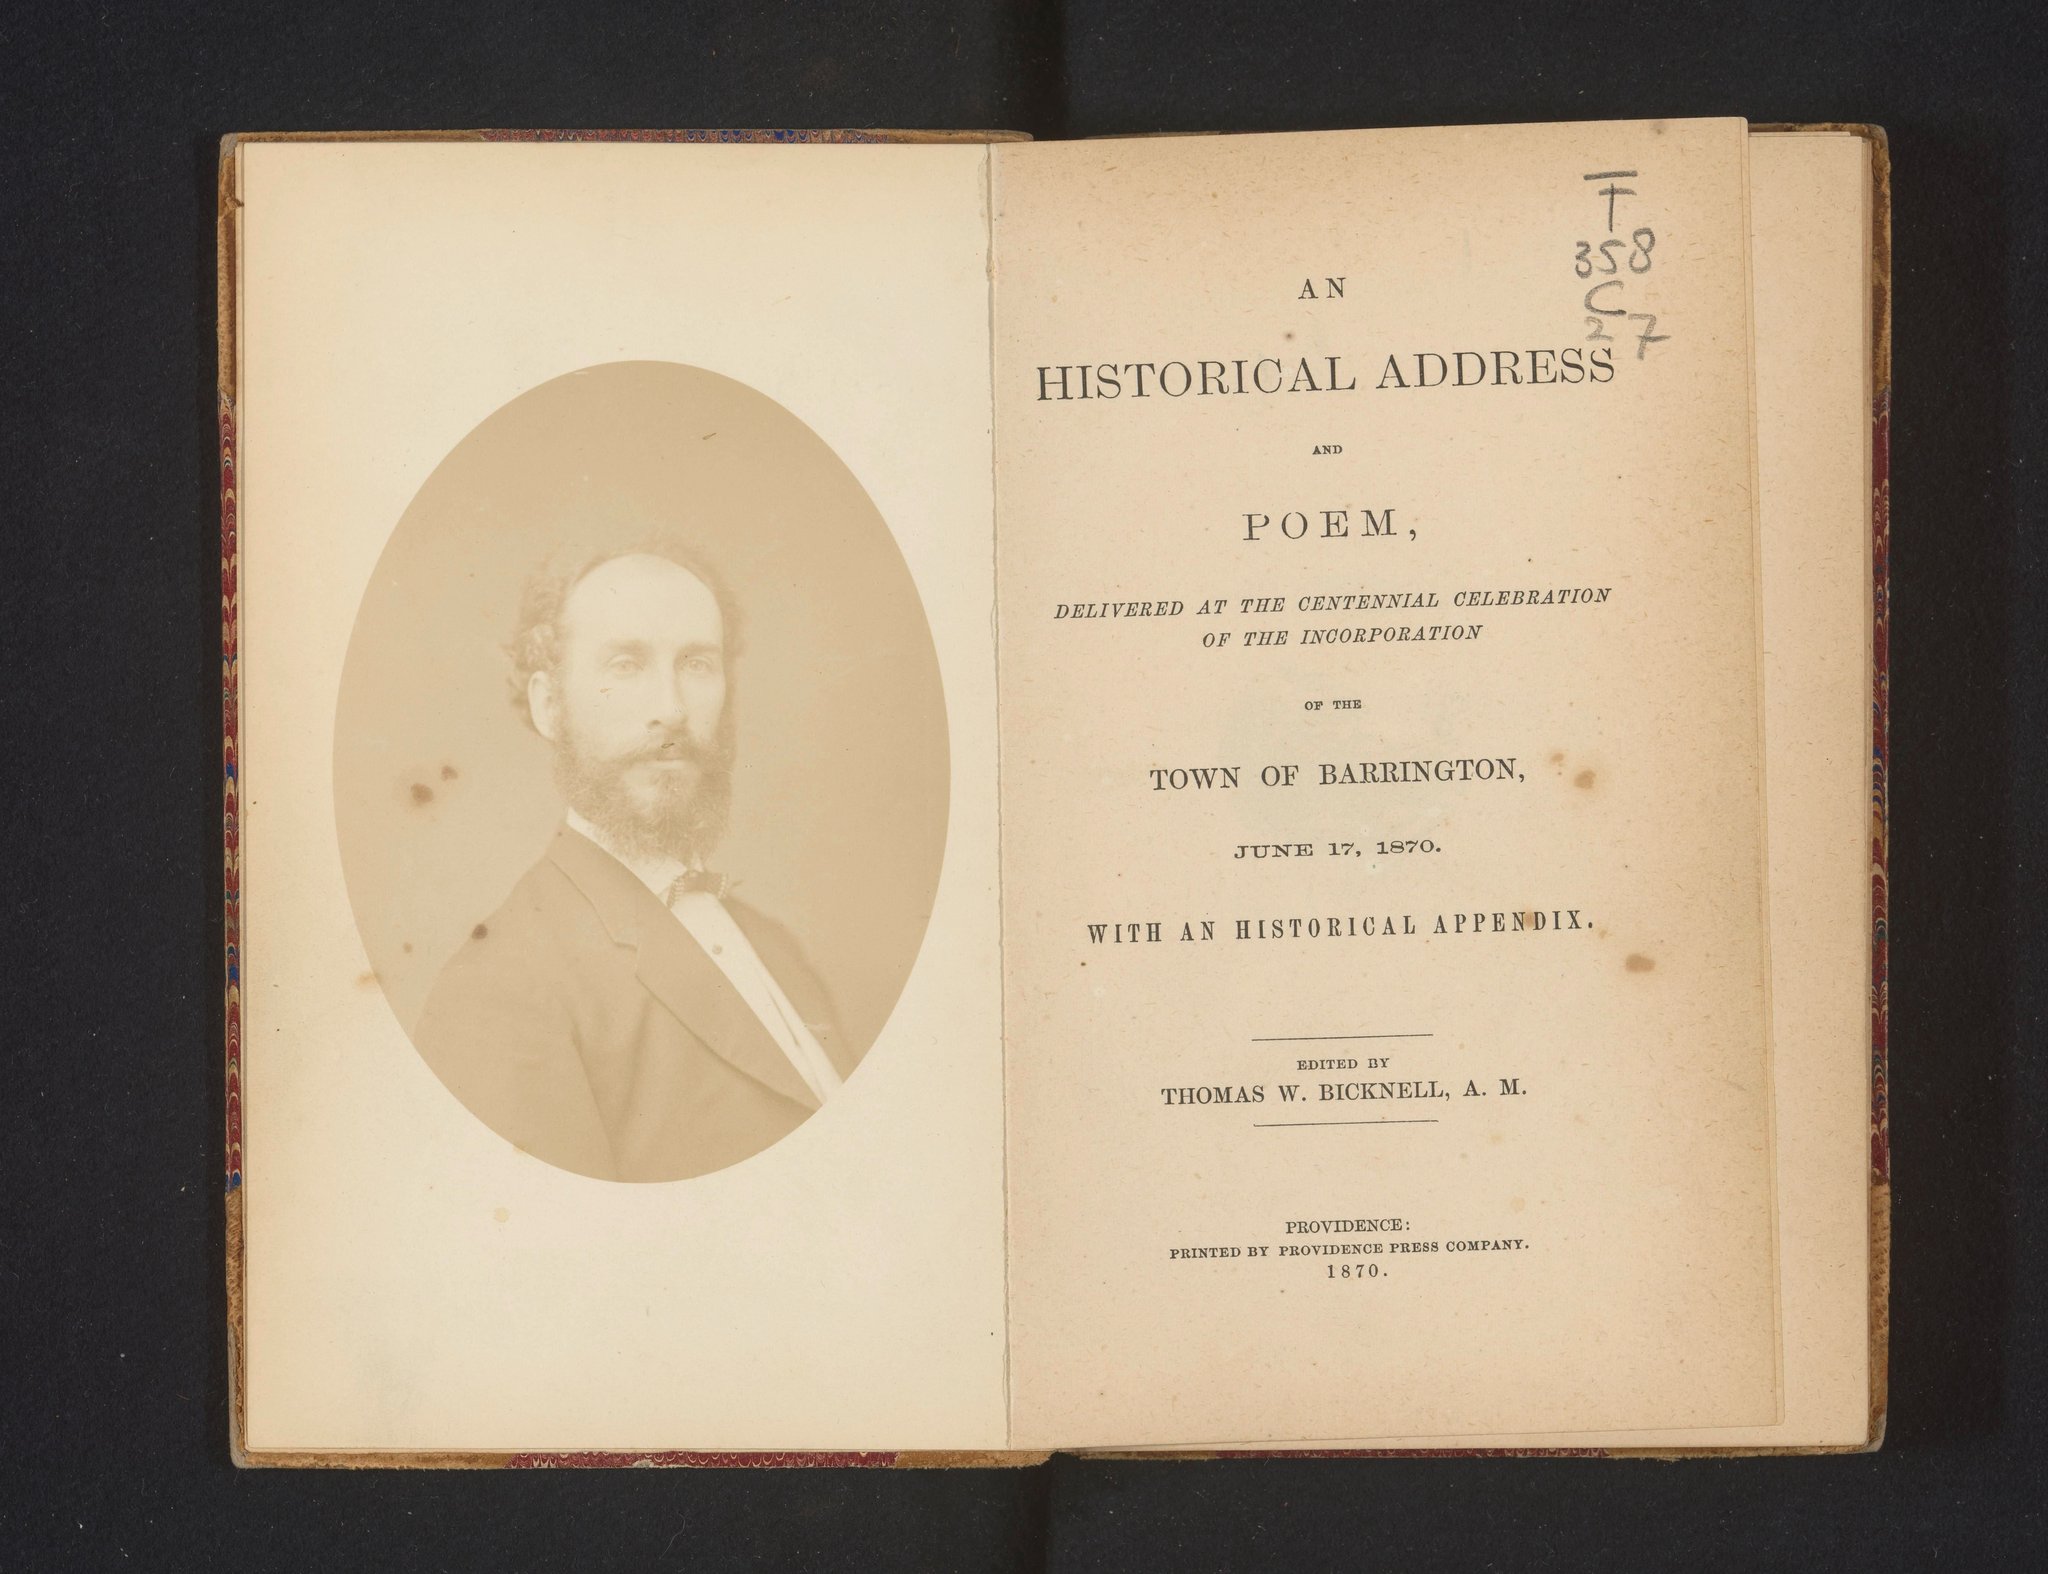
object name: page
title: Portret van Thomas W. Bicknell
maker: Anonymous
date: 1865-1870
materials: photographic support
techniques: salted paper print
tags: historical persons